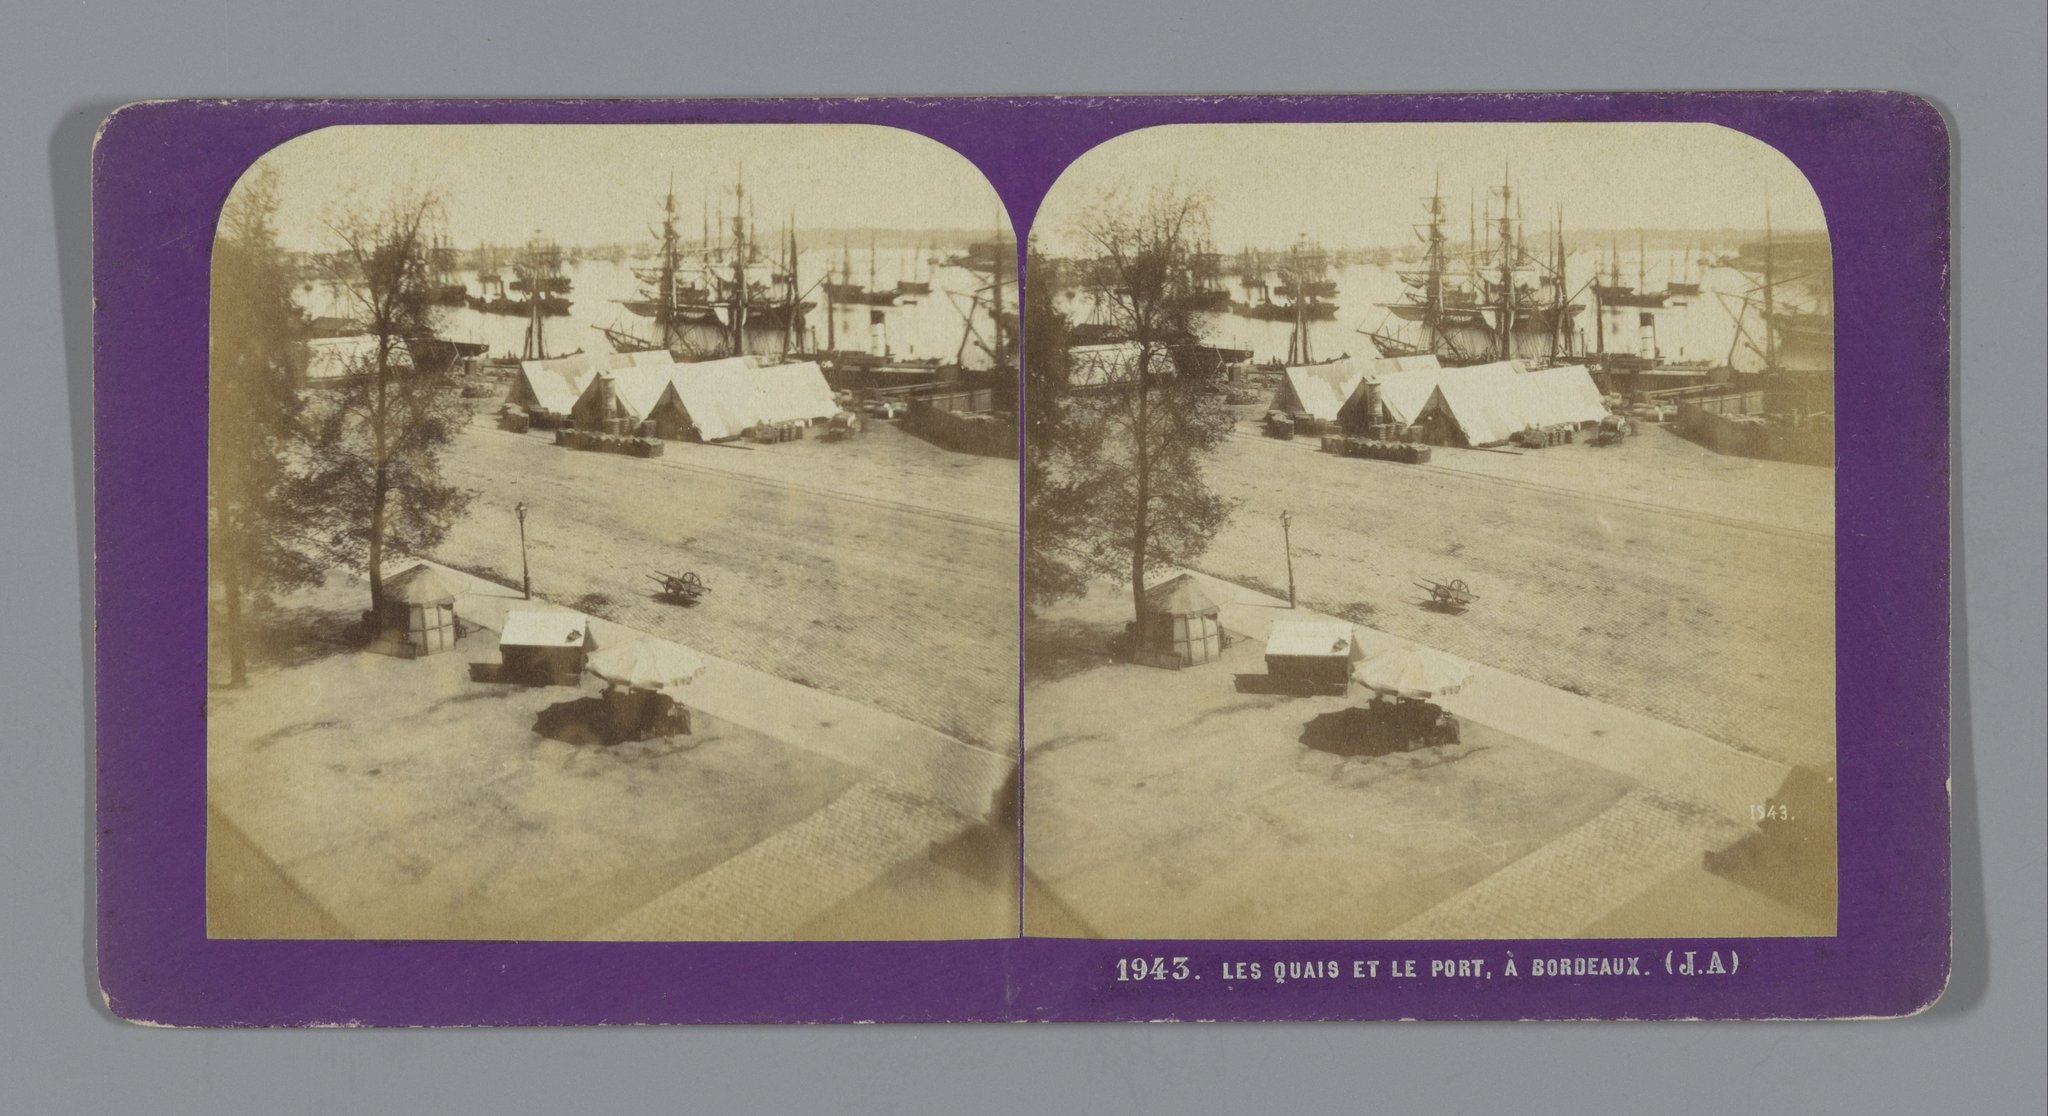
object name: stereograph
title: Gezicht op de haven van Bordeaux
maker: jean andrieu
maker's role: fotograaf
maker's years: 1816-1872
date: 1862-1876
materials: cardboard, photographic support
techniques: albumen print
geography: bordeaux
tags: harbour, ships (in general)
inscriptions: number: ‘1943.’